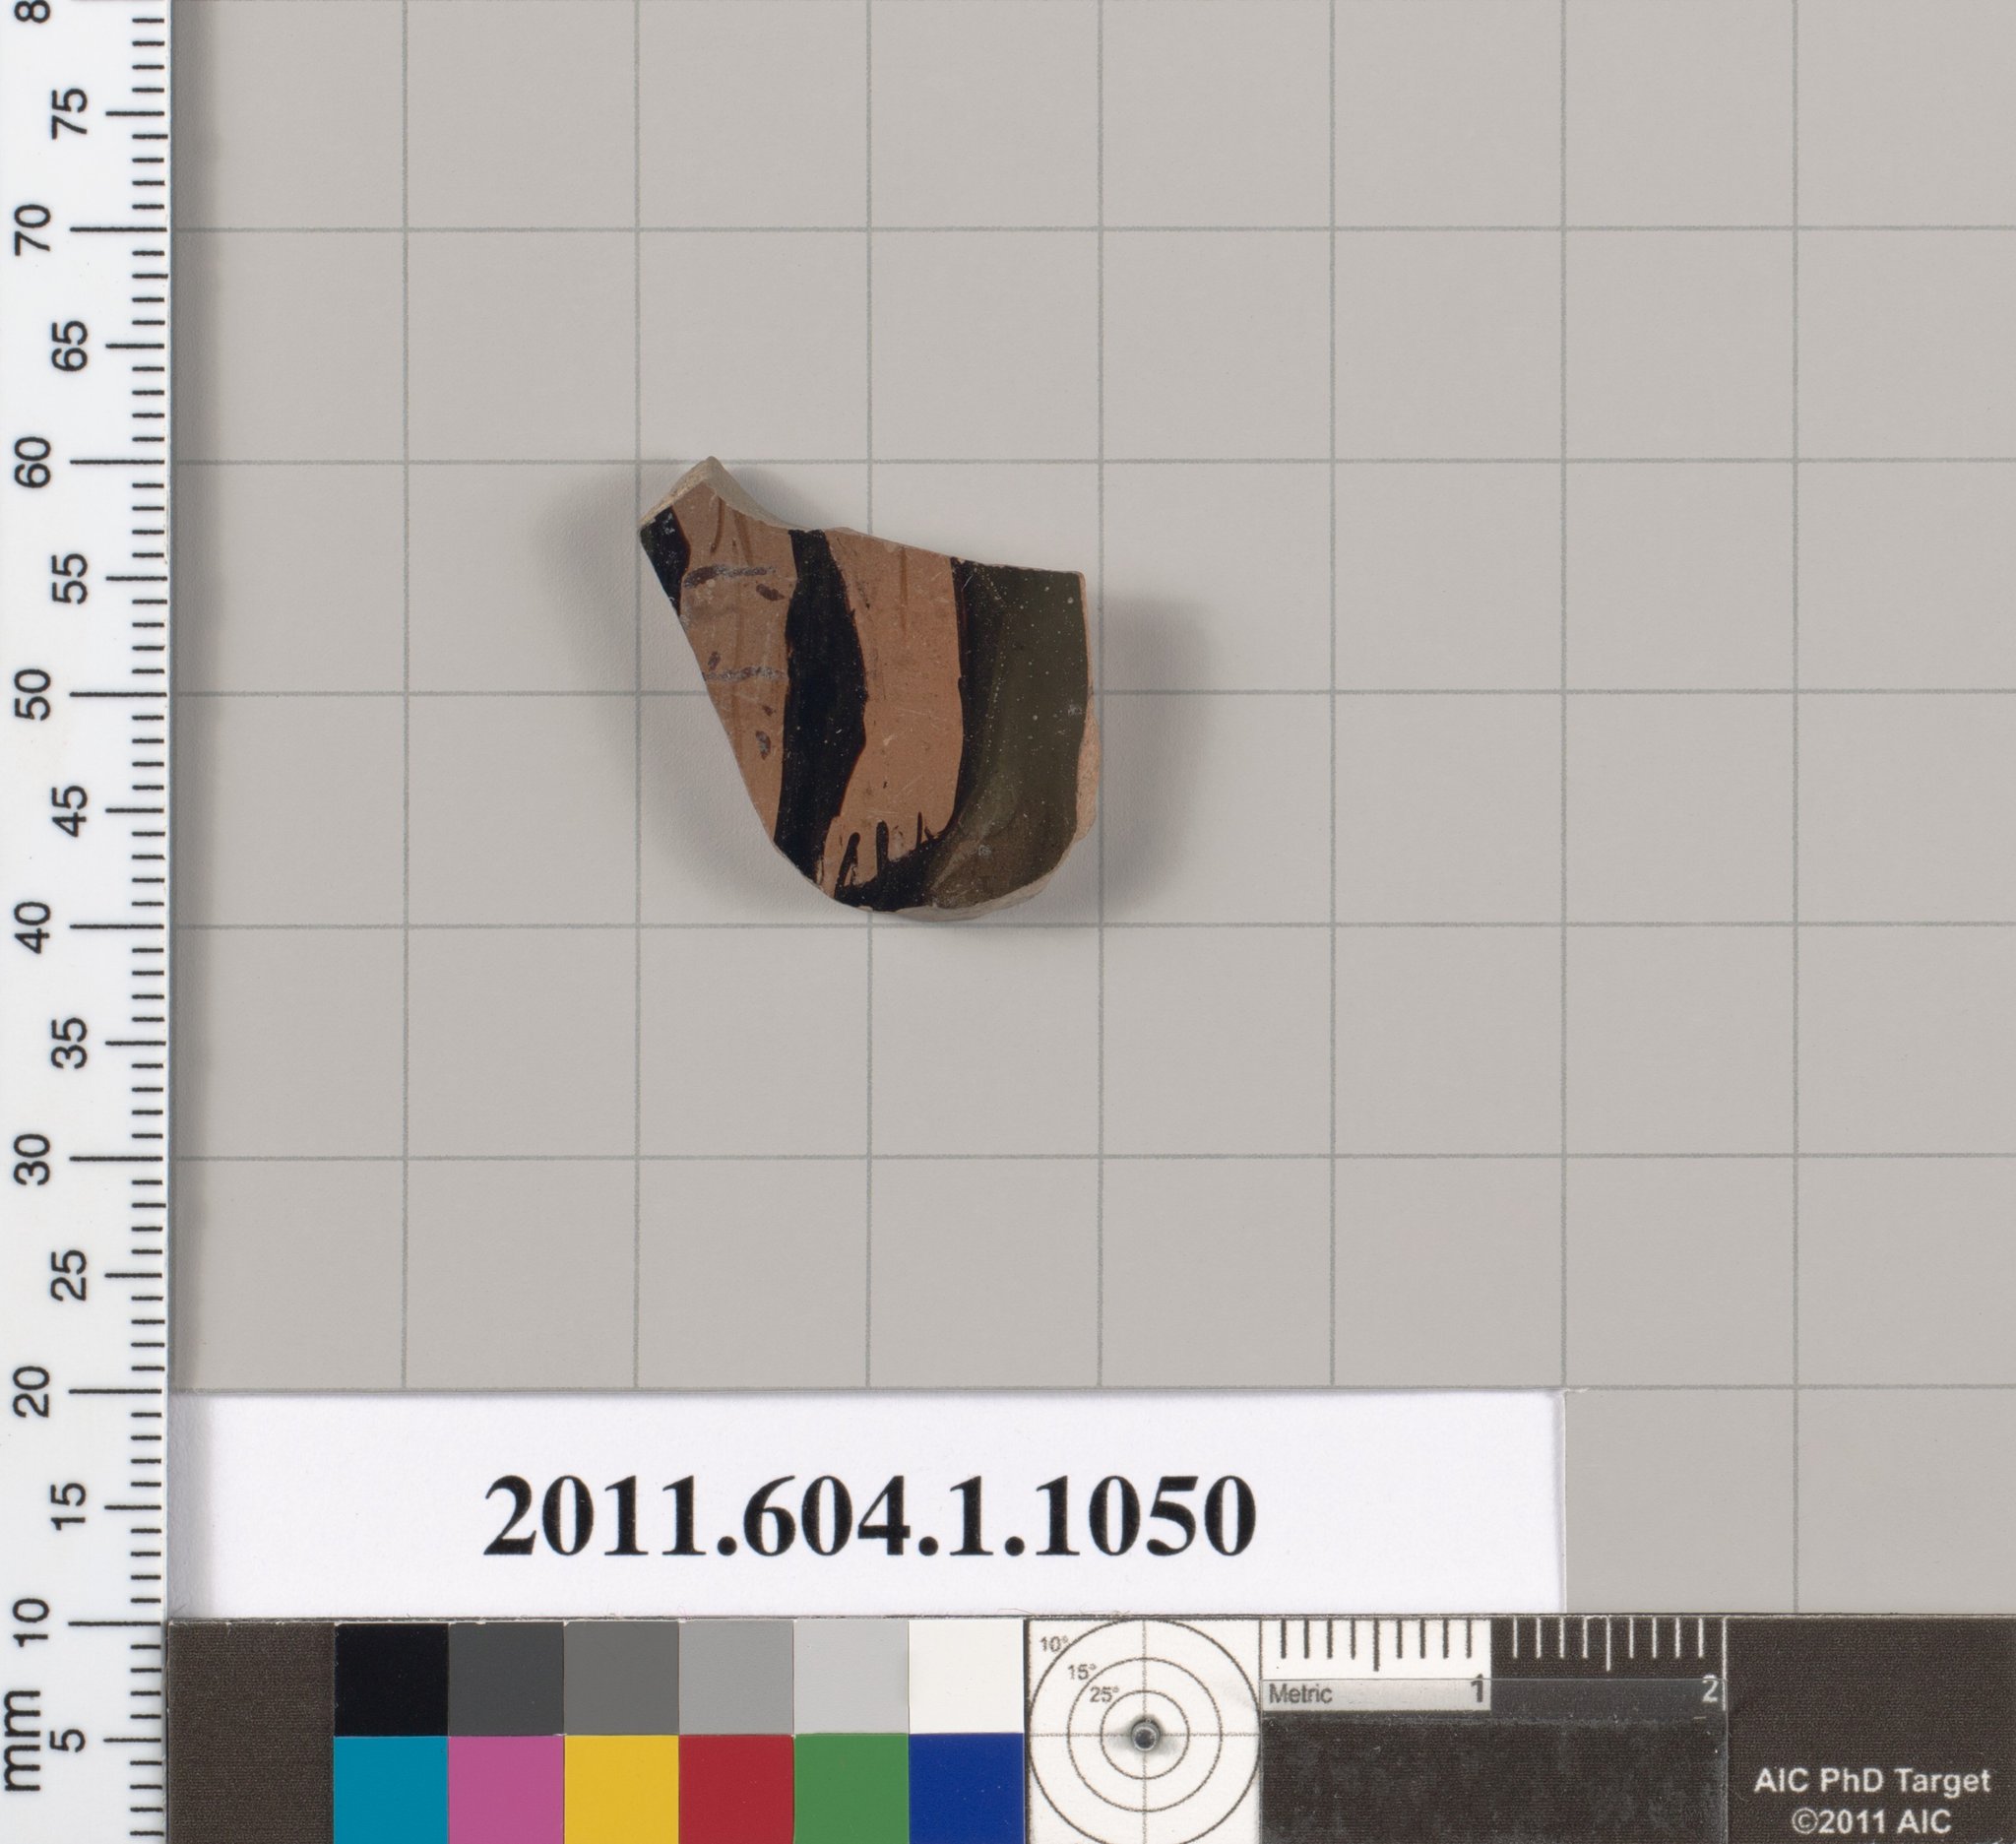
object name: kylix fragment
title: Terracotta fragment of a kylix (drinking cup)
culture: greek, attic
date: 475-451 BCE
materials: terracotta